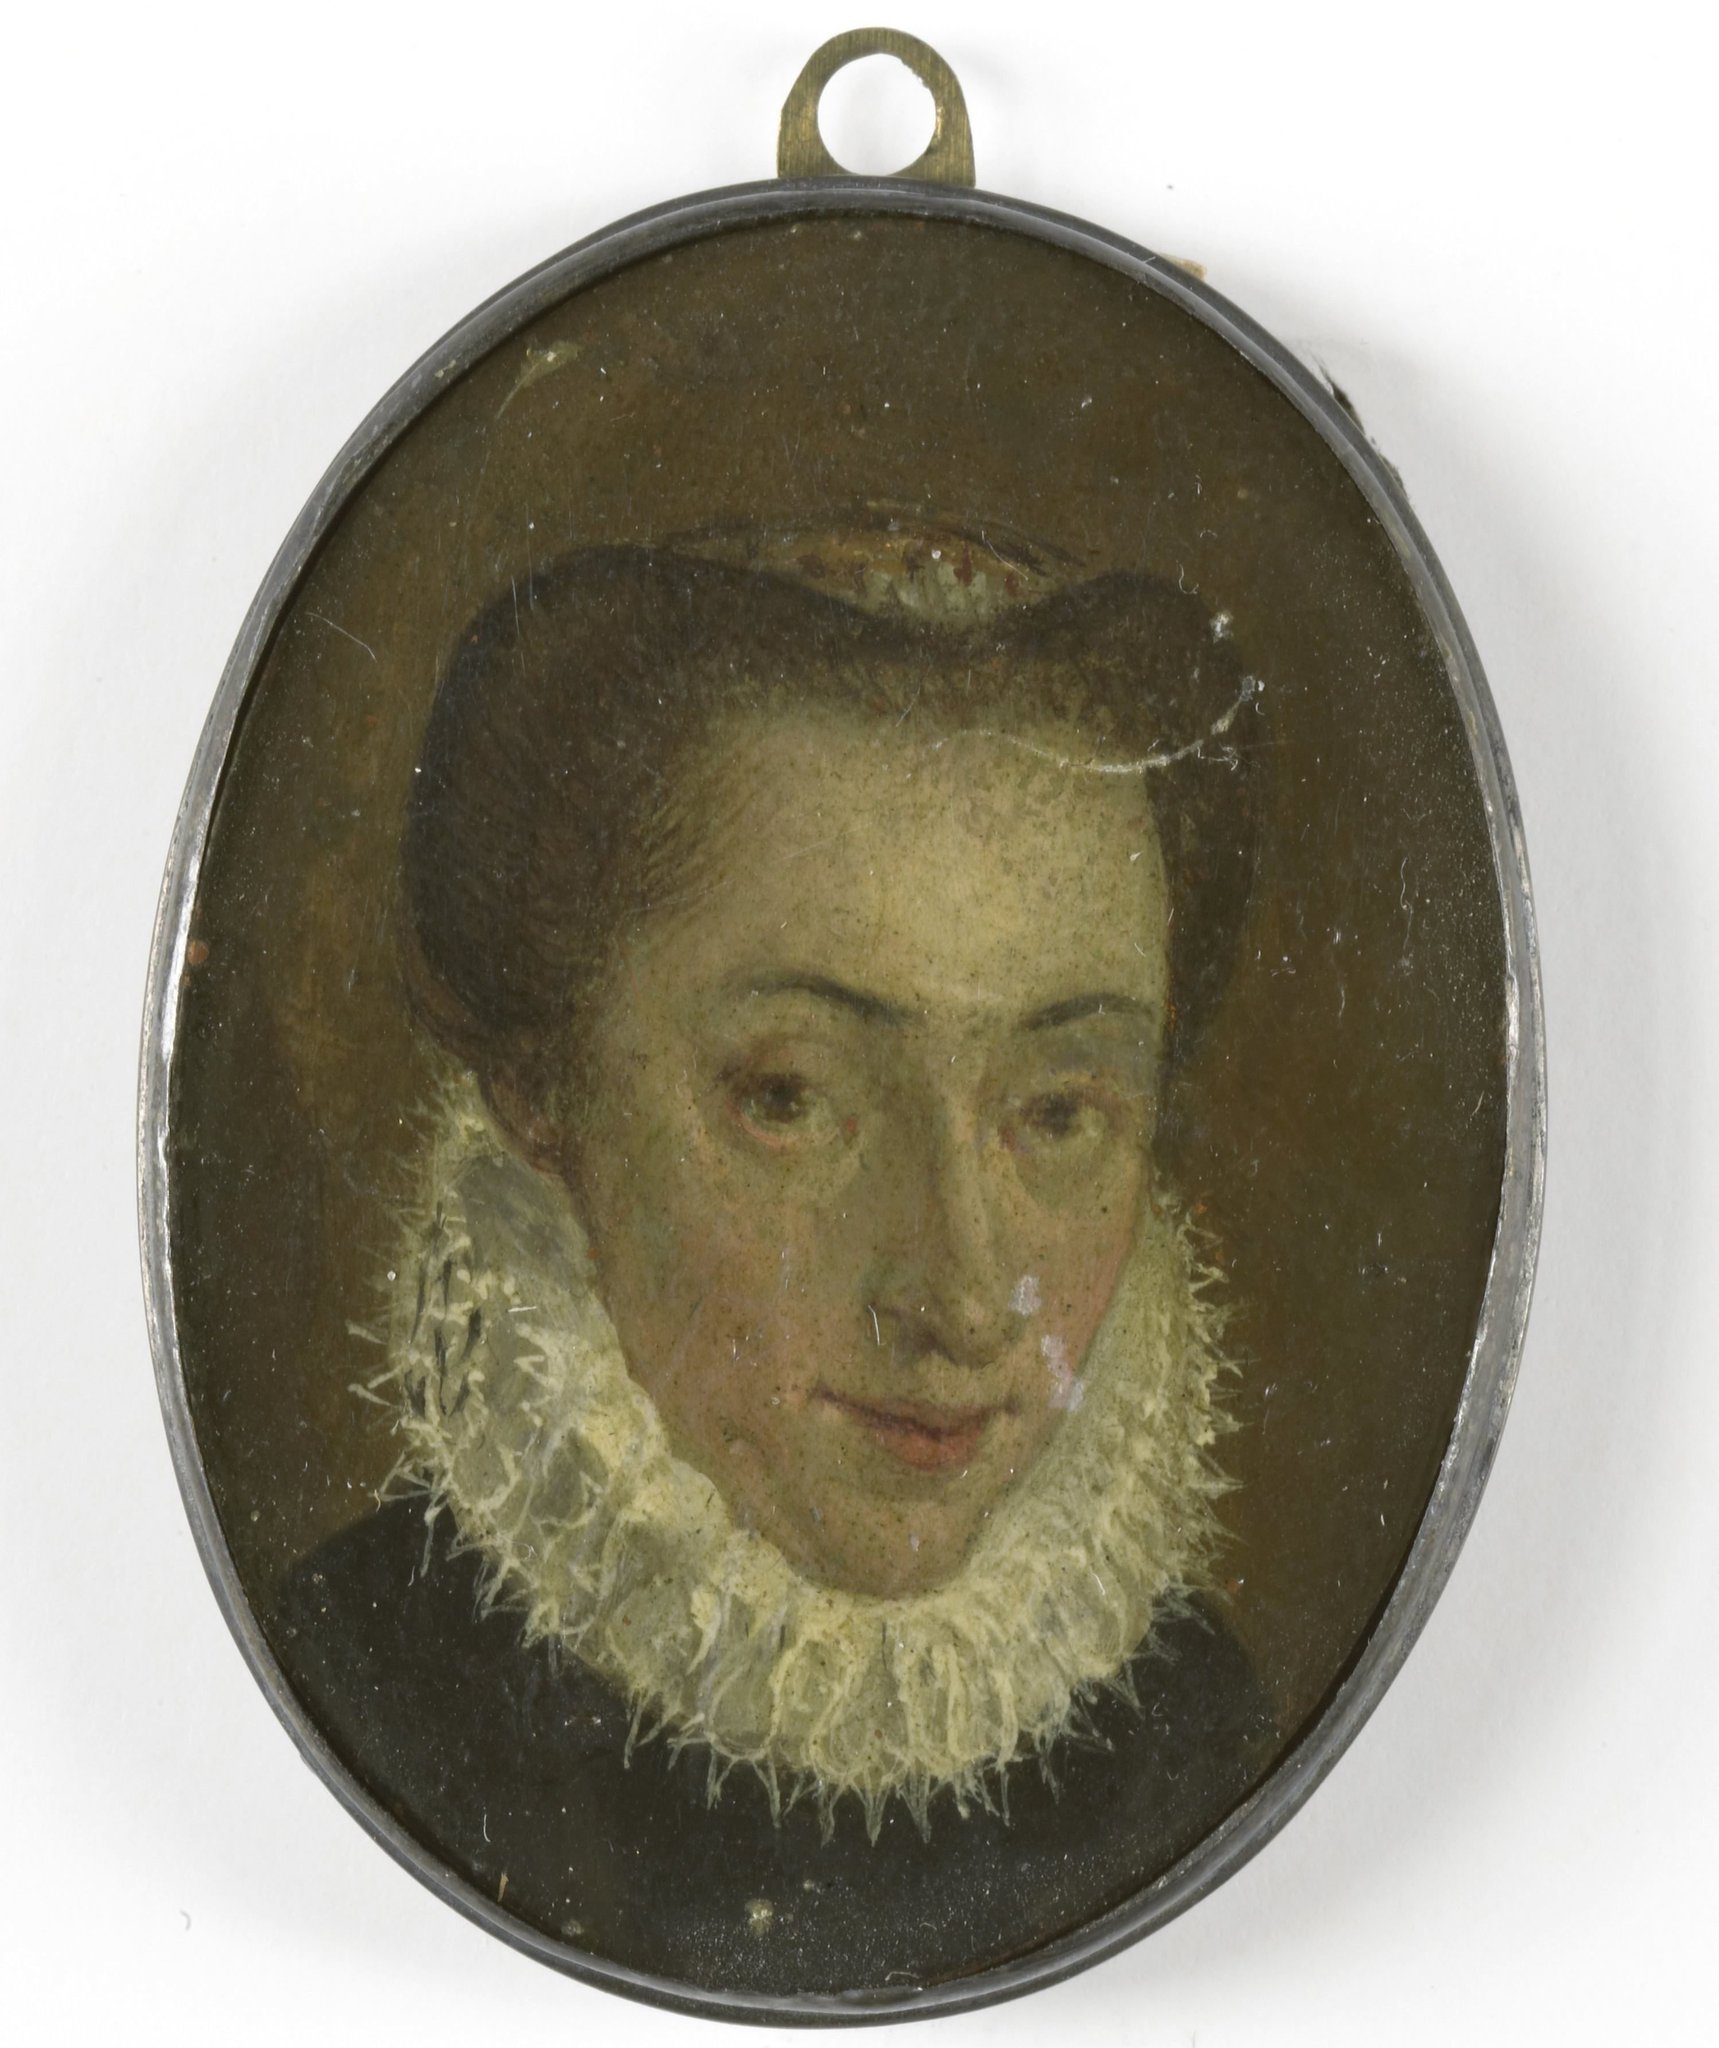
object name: painting, miniature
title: Portret van een vrouw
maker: Anonymous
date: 1575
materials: copper, oil, silver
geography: low countries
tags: historical persons not known by name - bb - woman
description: Portret van een vrouw. Buste, naar links, aanziend. Onderdeel van de collectie portretminiaturen.